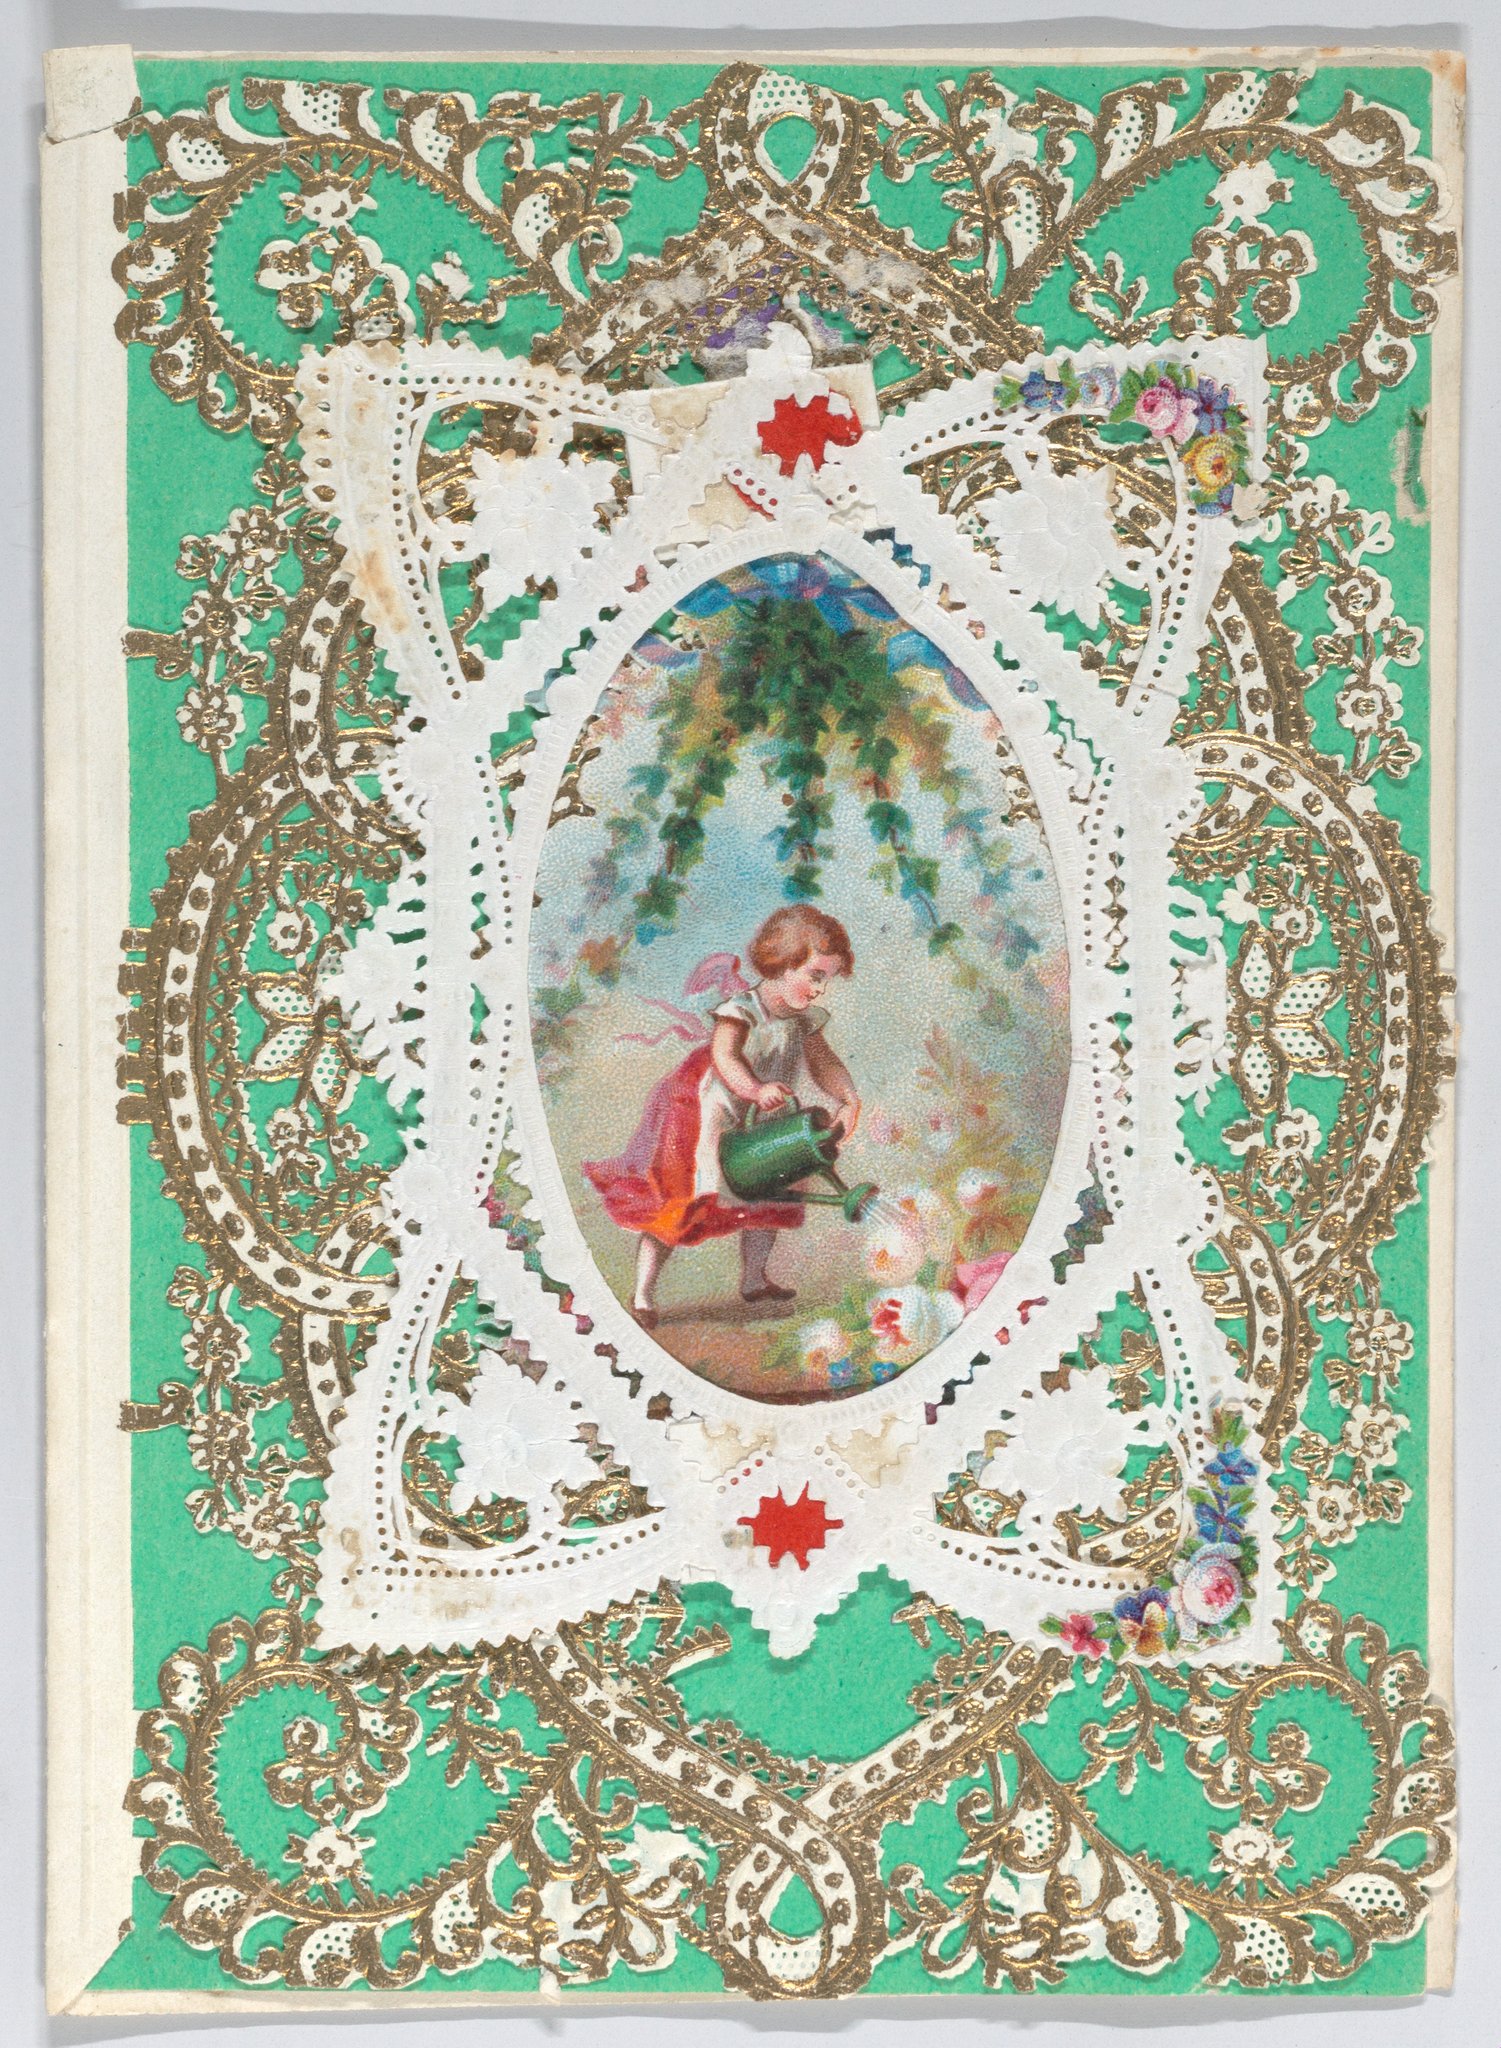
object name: valentine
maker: Anonymous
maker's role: artist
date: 1878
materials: ink, lace, paper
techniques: chromolithography, embossing, gilding, open work